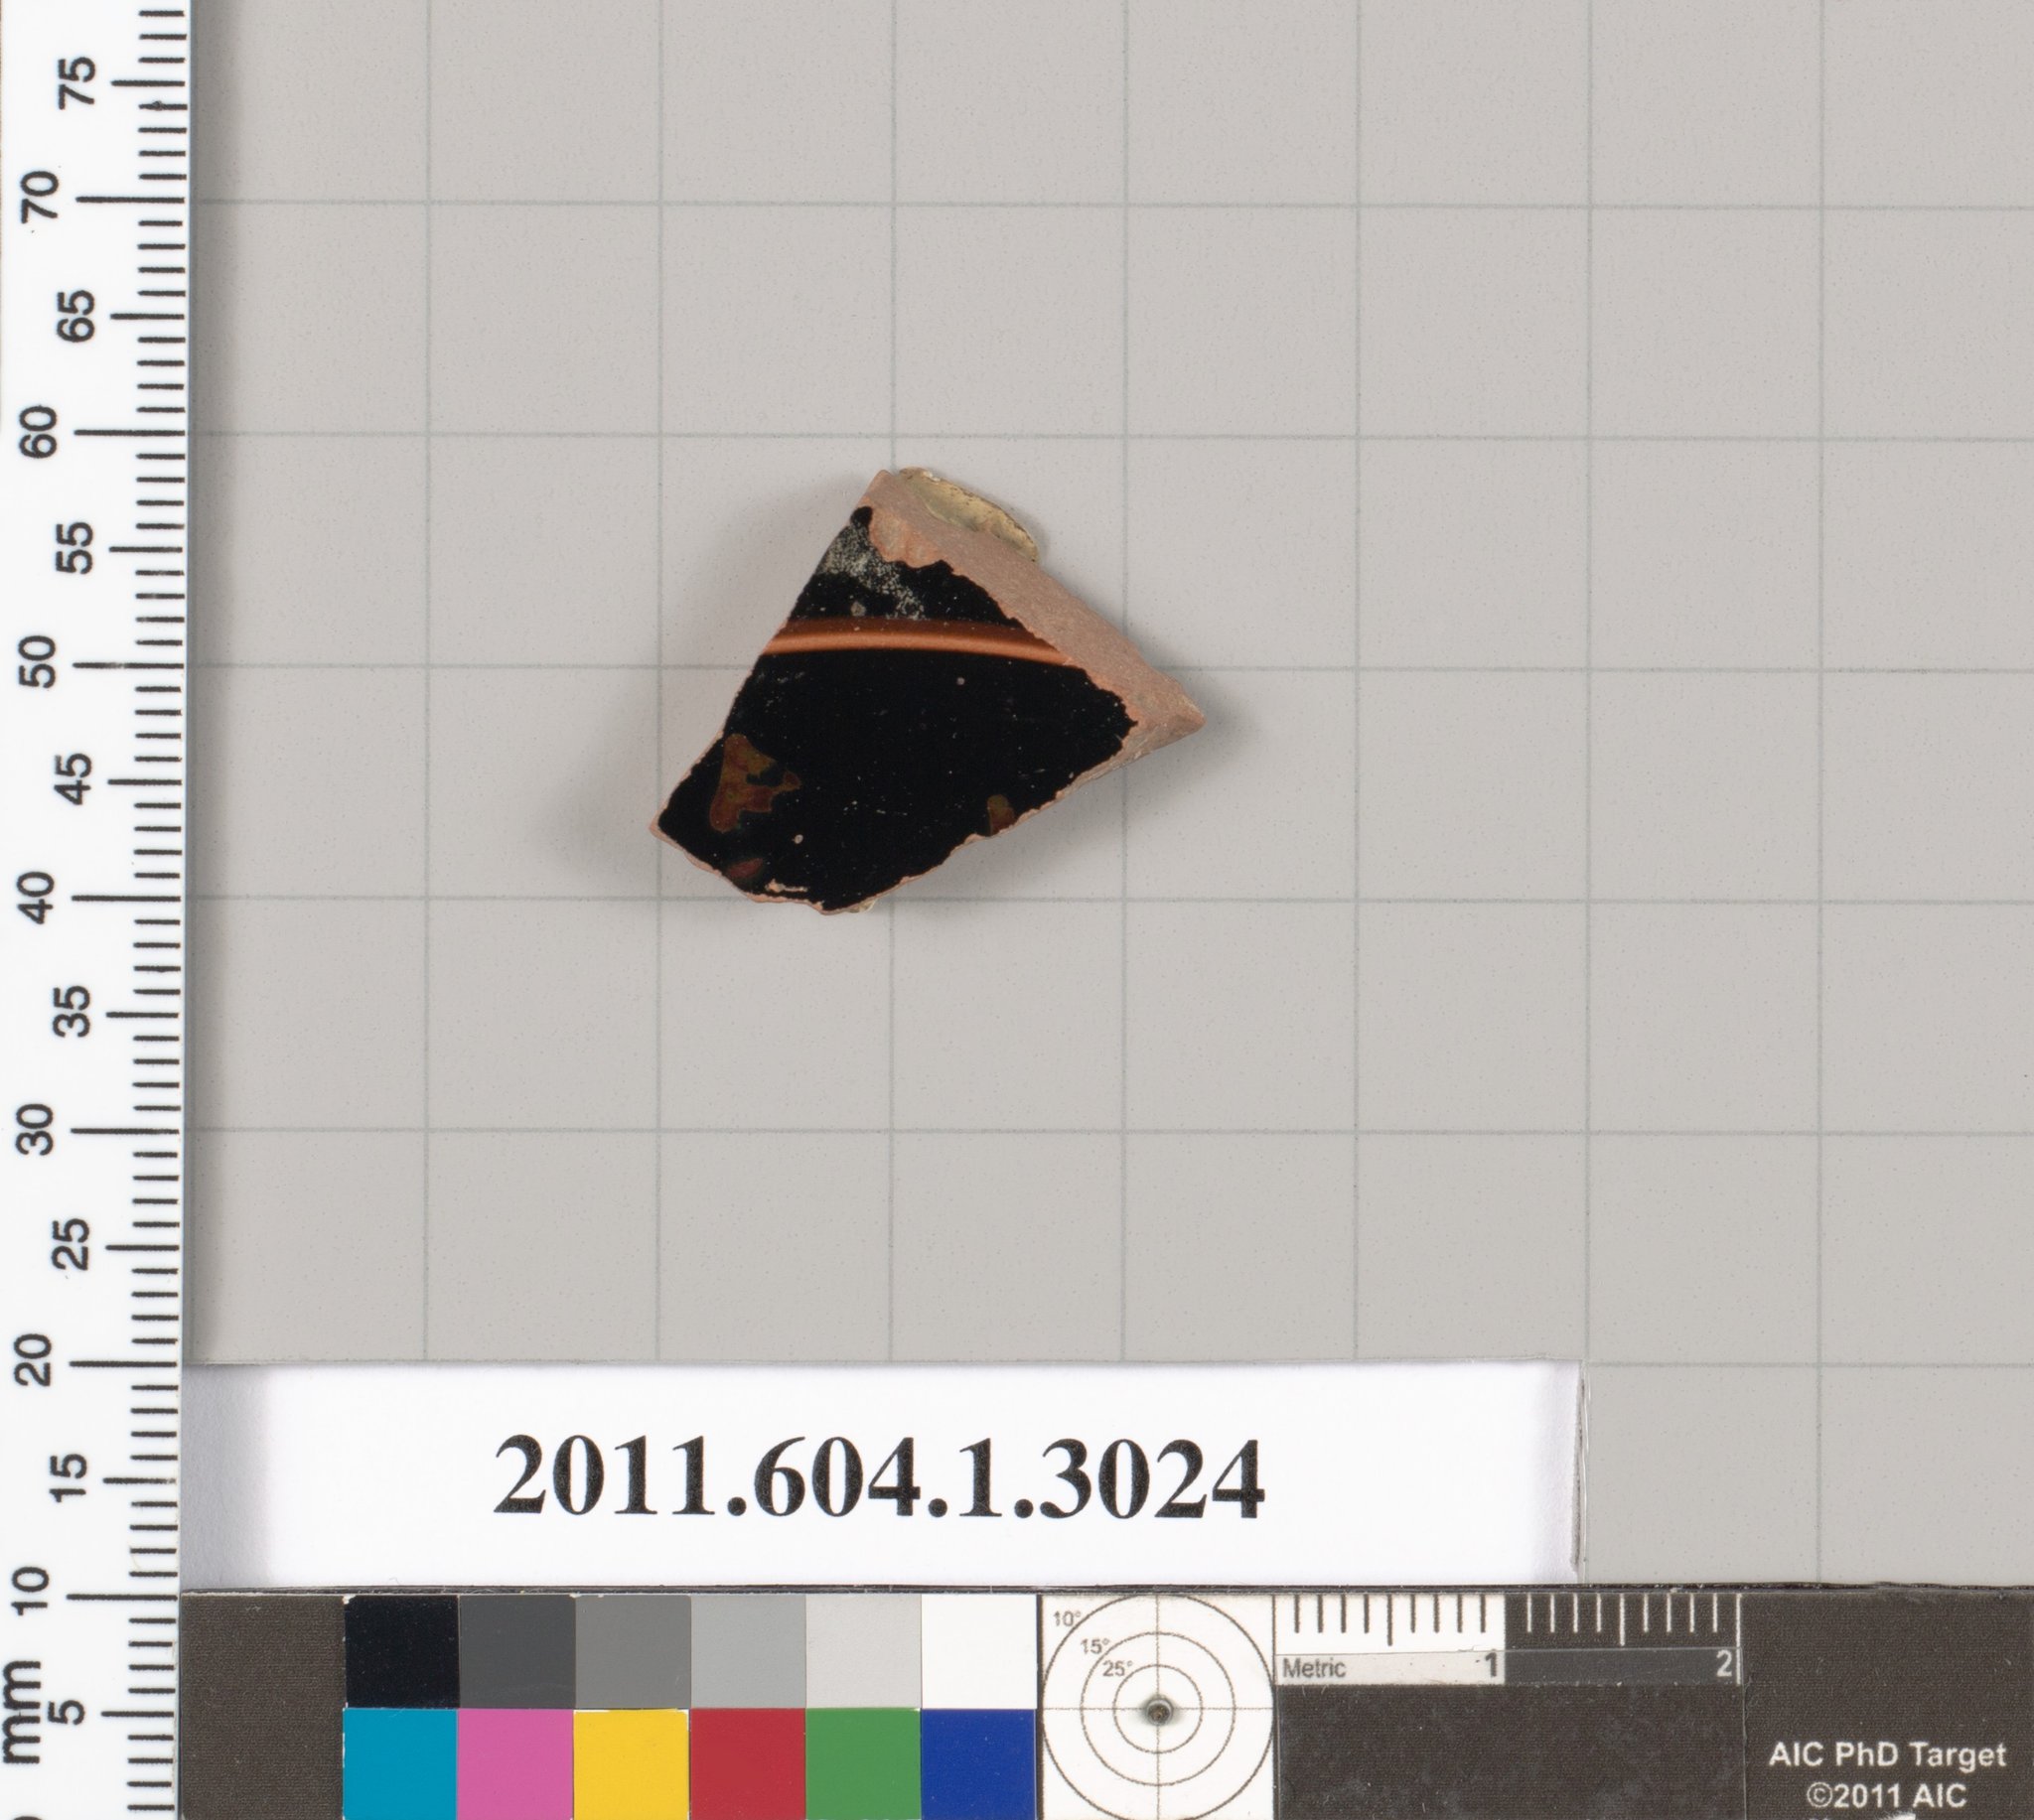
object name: kylix fragment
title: Terracotta fragment of a kylix (drinking cup)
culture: greek, attic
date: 520-480 BCE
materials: terracotta